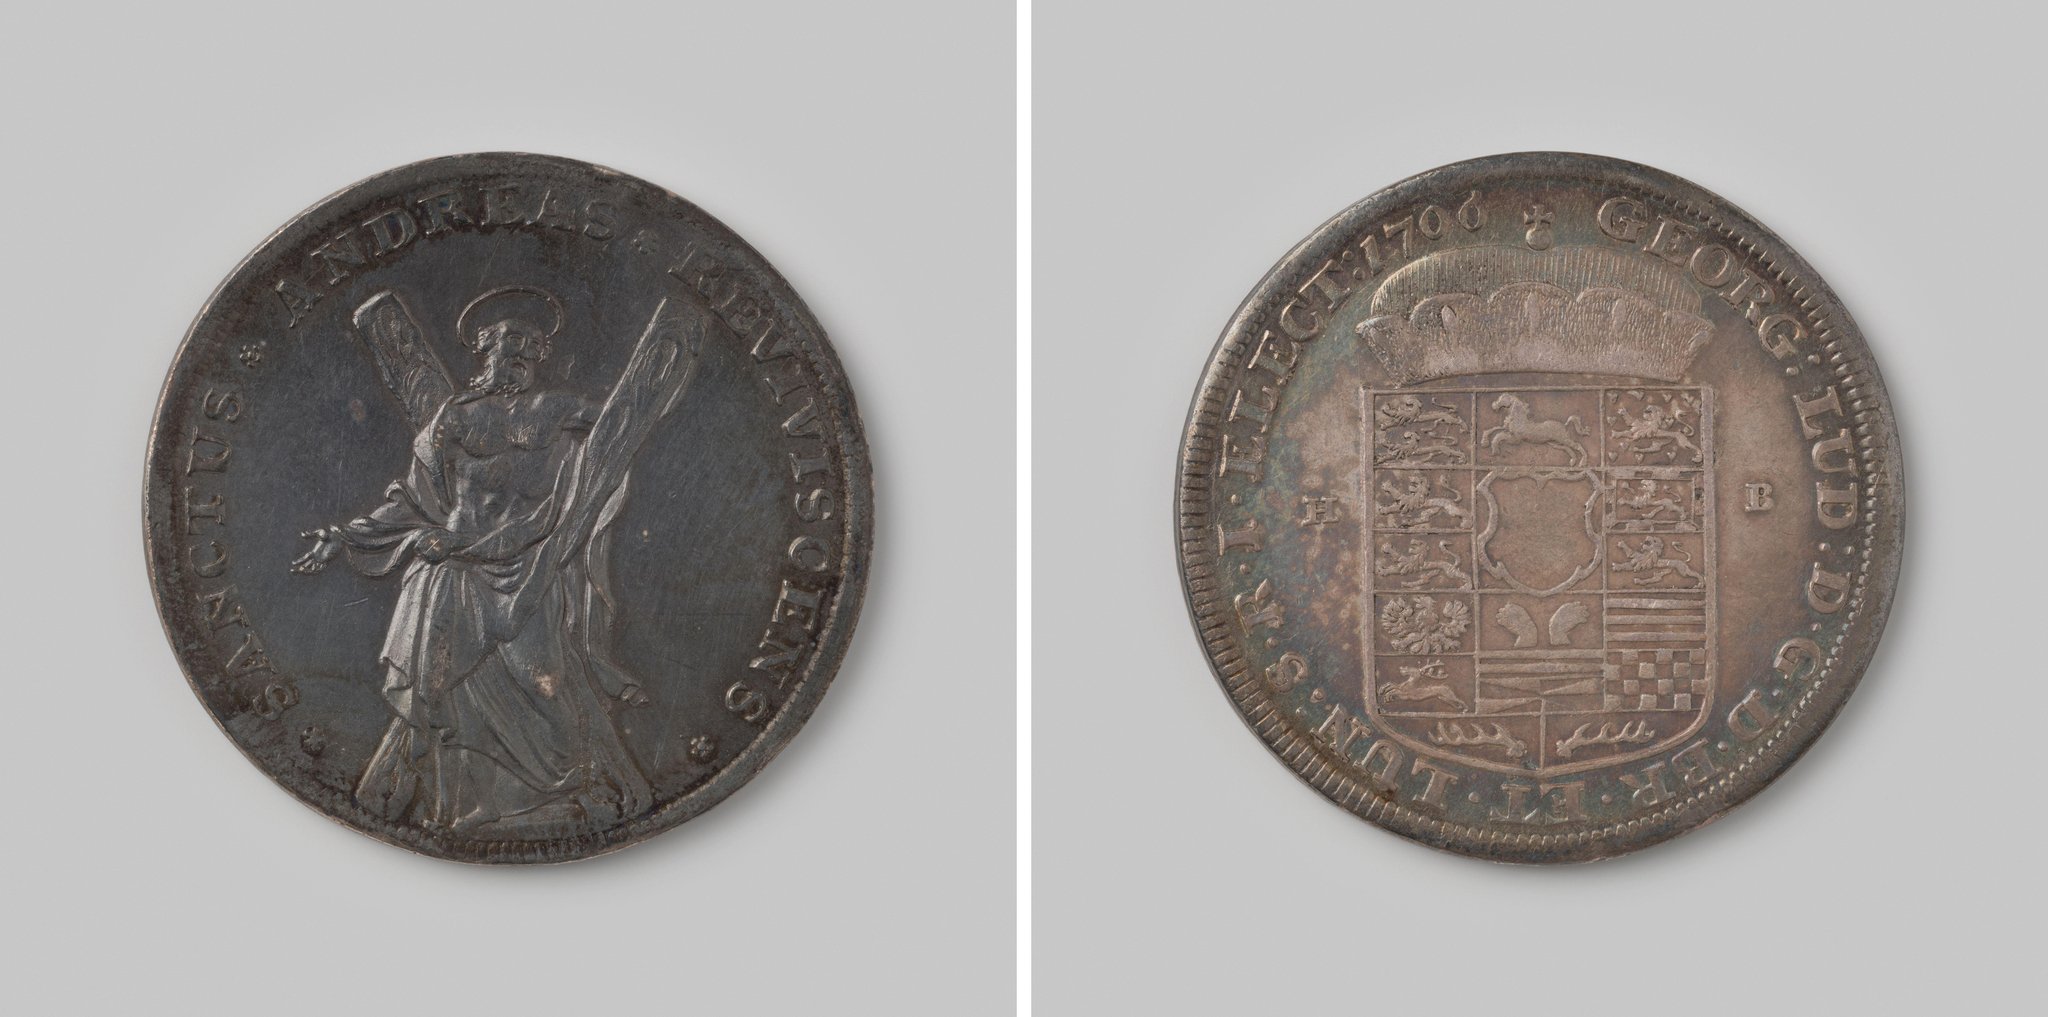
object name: andreastaler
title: Andreasthaler uit Brunswijk-Luneburg-Calenberg-Hannover van Georg I Ludwig, 1706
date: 1706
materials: silver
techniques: striking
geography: clausthal-zellerfeld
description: Zilveren munt. Voorzijde: gekroond samengesteld wapenschild. Jaartal bovenaan aan het eind van het omschrift. Keerzijde: heilige Andreas met kruis. Gladde rand.